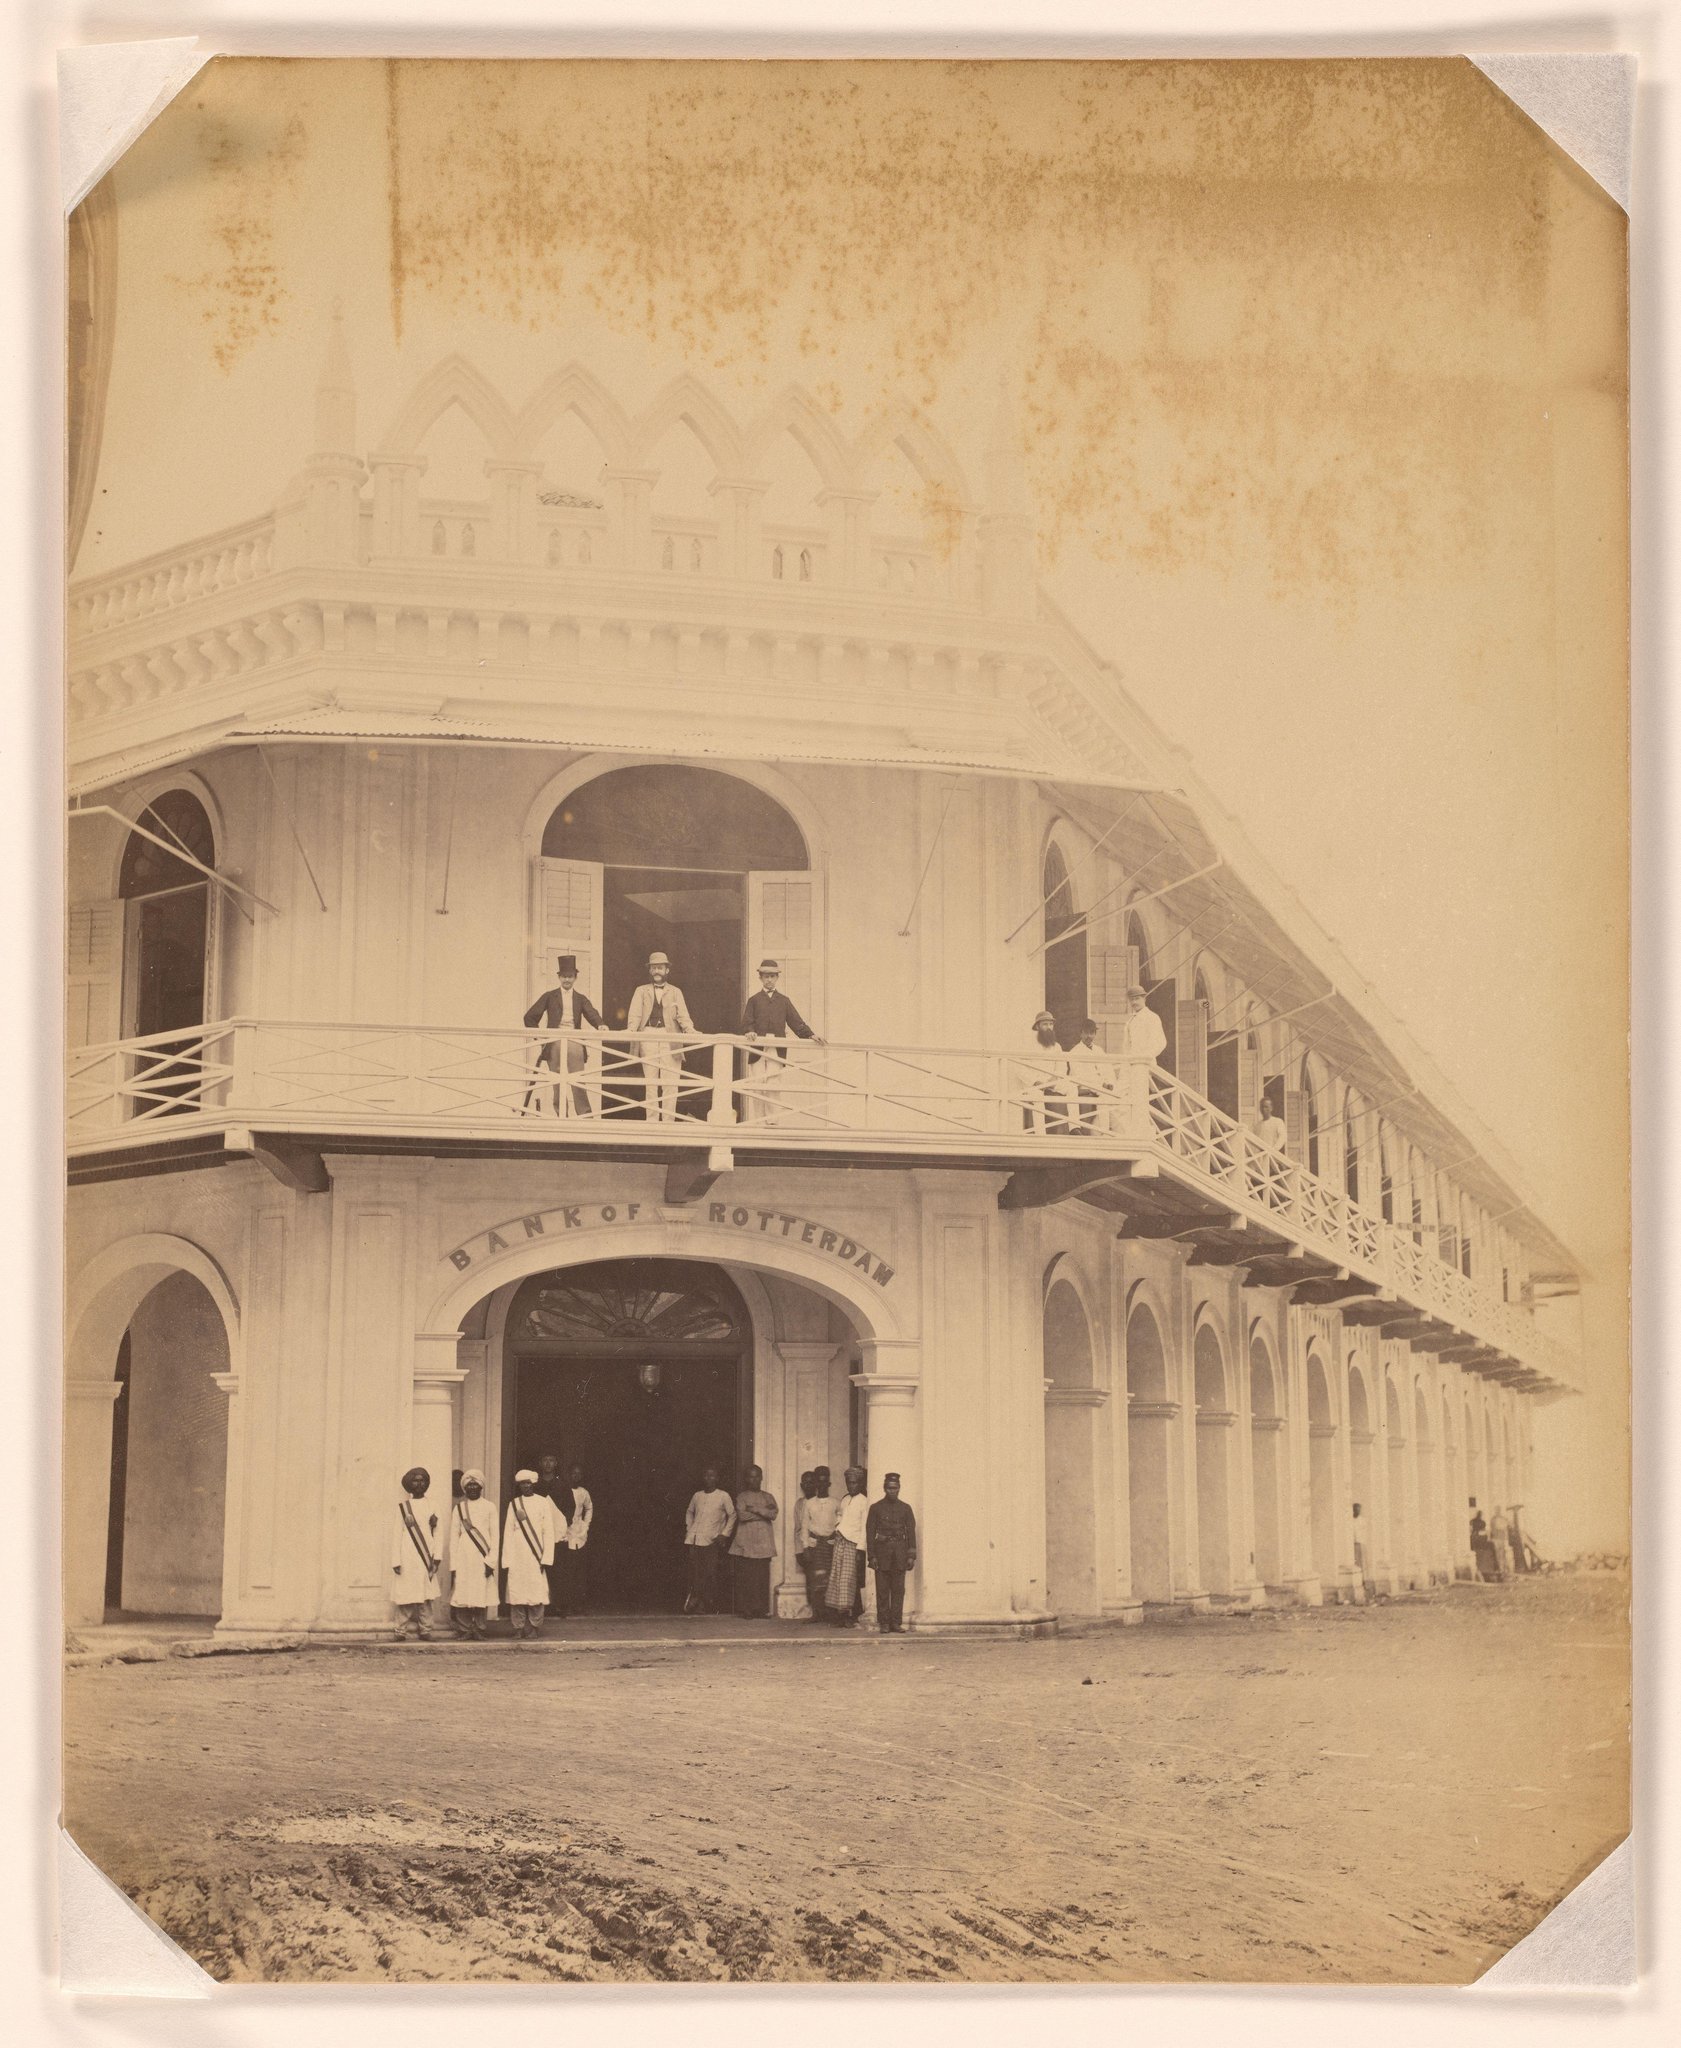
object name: photograph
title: Bank of Rotterdam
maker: Anonymous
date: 1865-1875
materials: cardboard, paper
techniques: albumen print